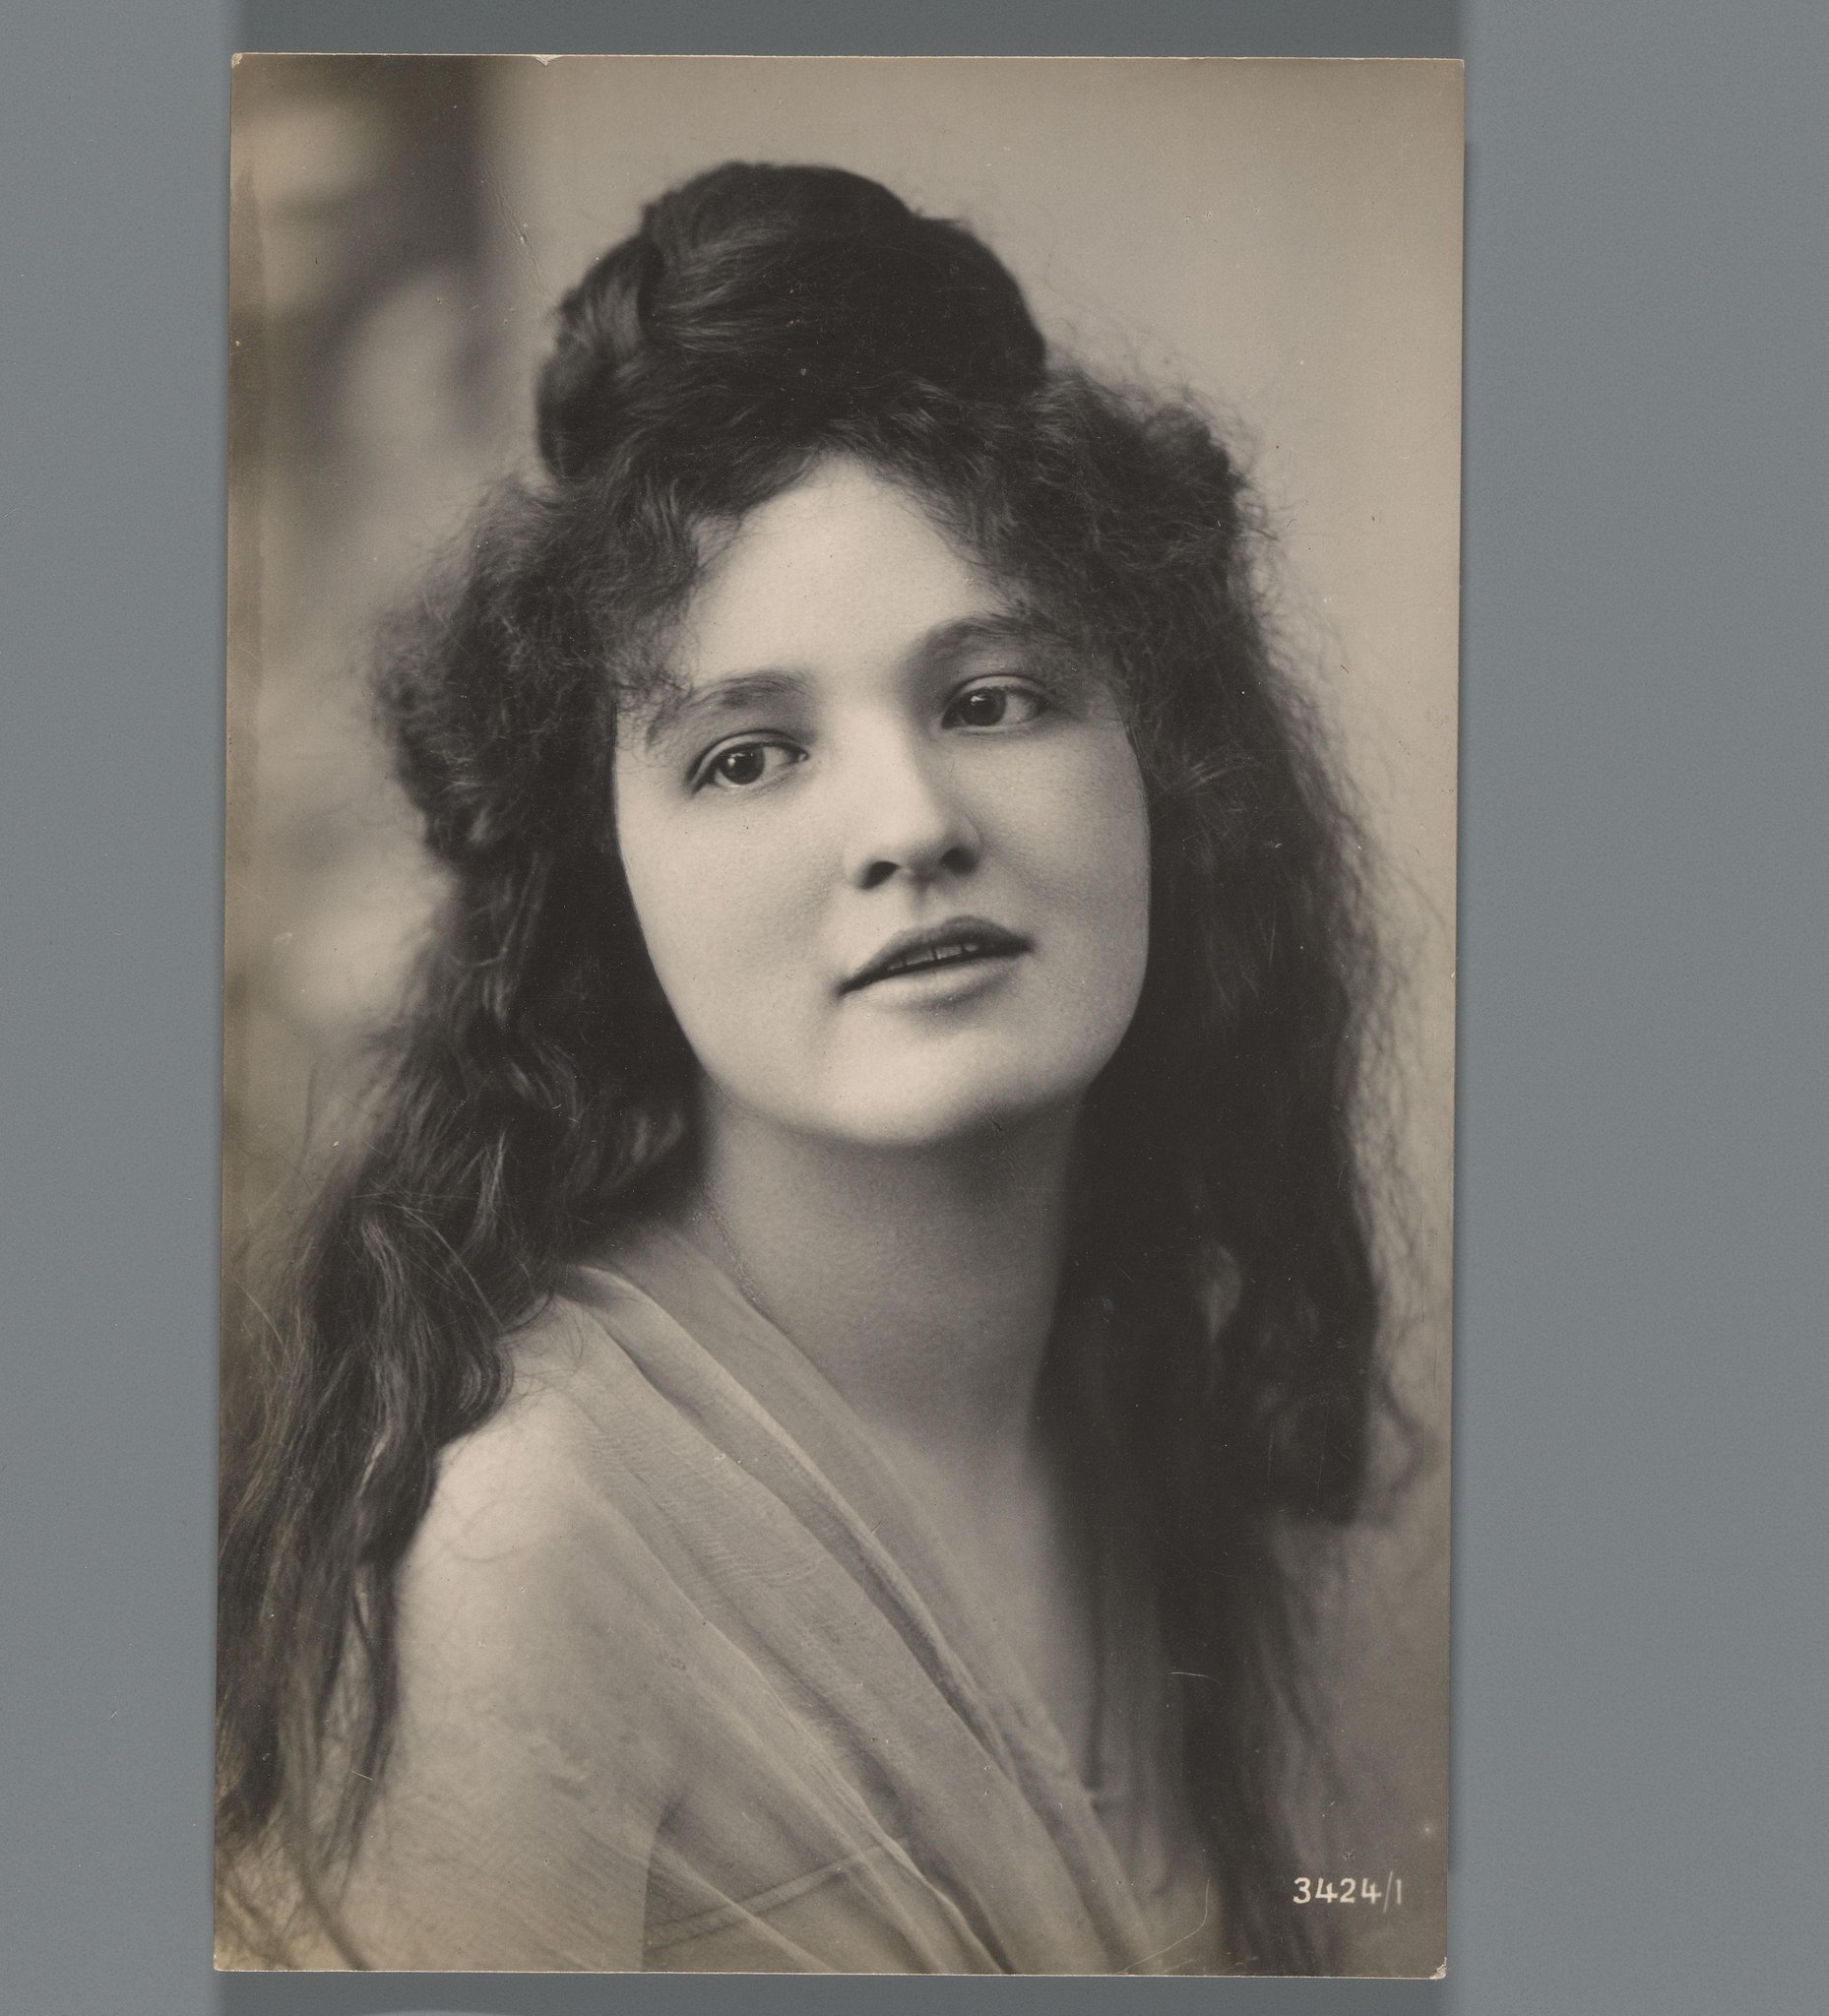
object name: photograph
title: Portret van een onbekende jonge vrouw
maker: Anonymous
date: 1900-1909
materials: paper, ink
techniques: gelatin silver print, pen, writing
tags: anonymous historical person portrayed - bb - woman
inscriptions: inscription: ‘Artje./ Mejuf. Anna van Aalst/ p/a Mevrouw de Wed:/ Sillenis/ Kerk-Avezaath.’, number: ‘3424/1’